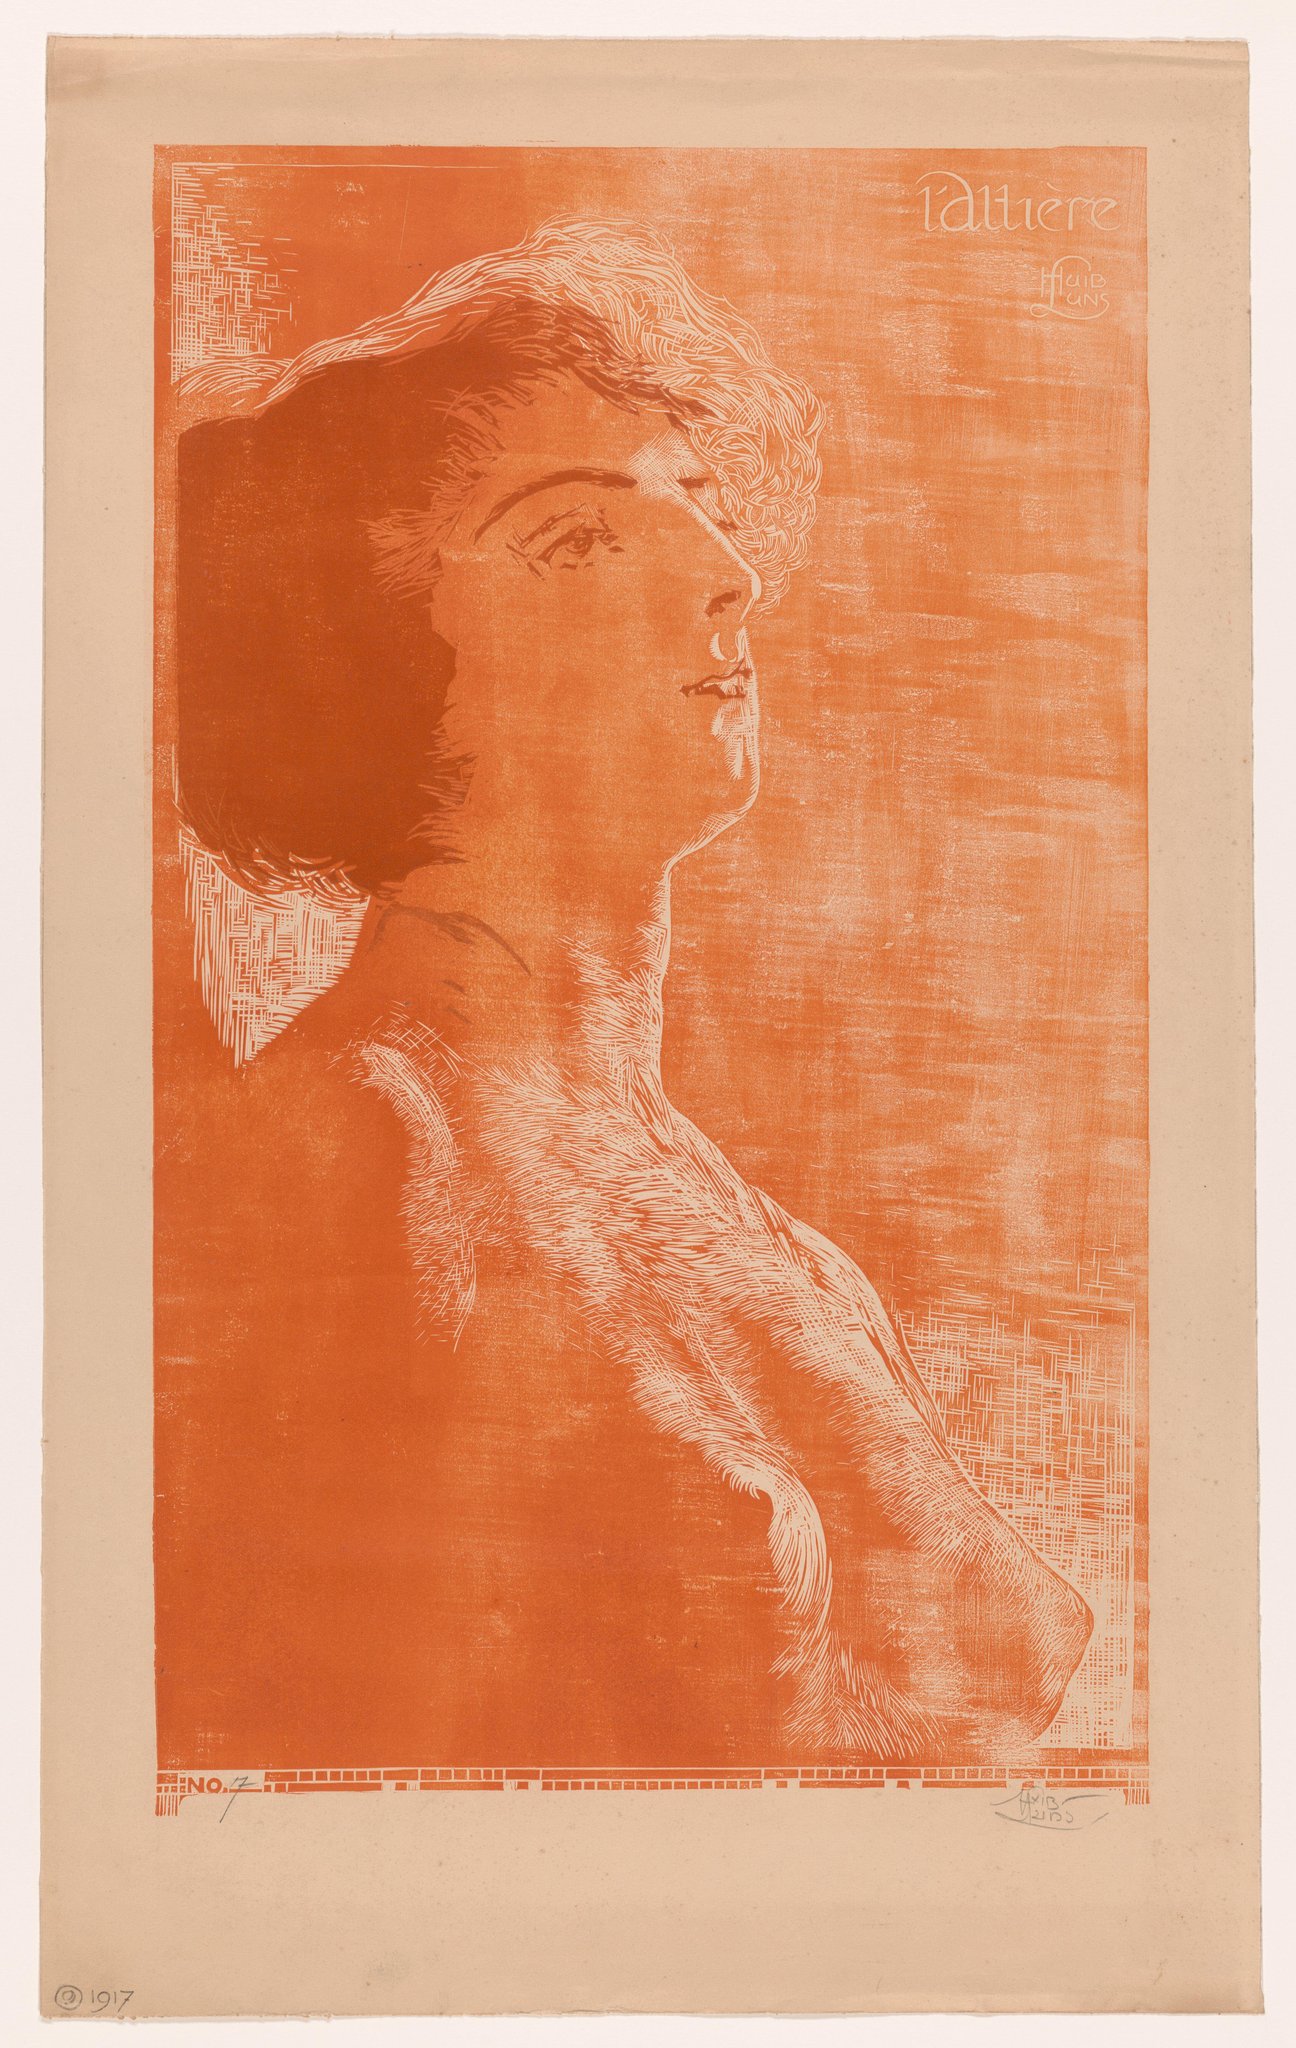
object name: print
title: L'altière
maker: huib luns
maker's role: draughtsman, print maker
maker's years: 1881-1942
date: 1917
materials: paper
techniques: woodcut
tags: adult woman, historical persons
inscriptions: number: ‘No. 7’